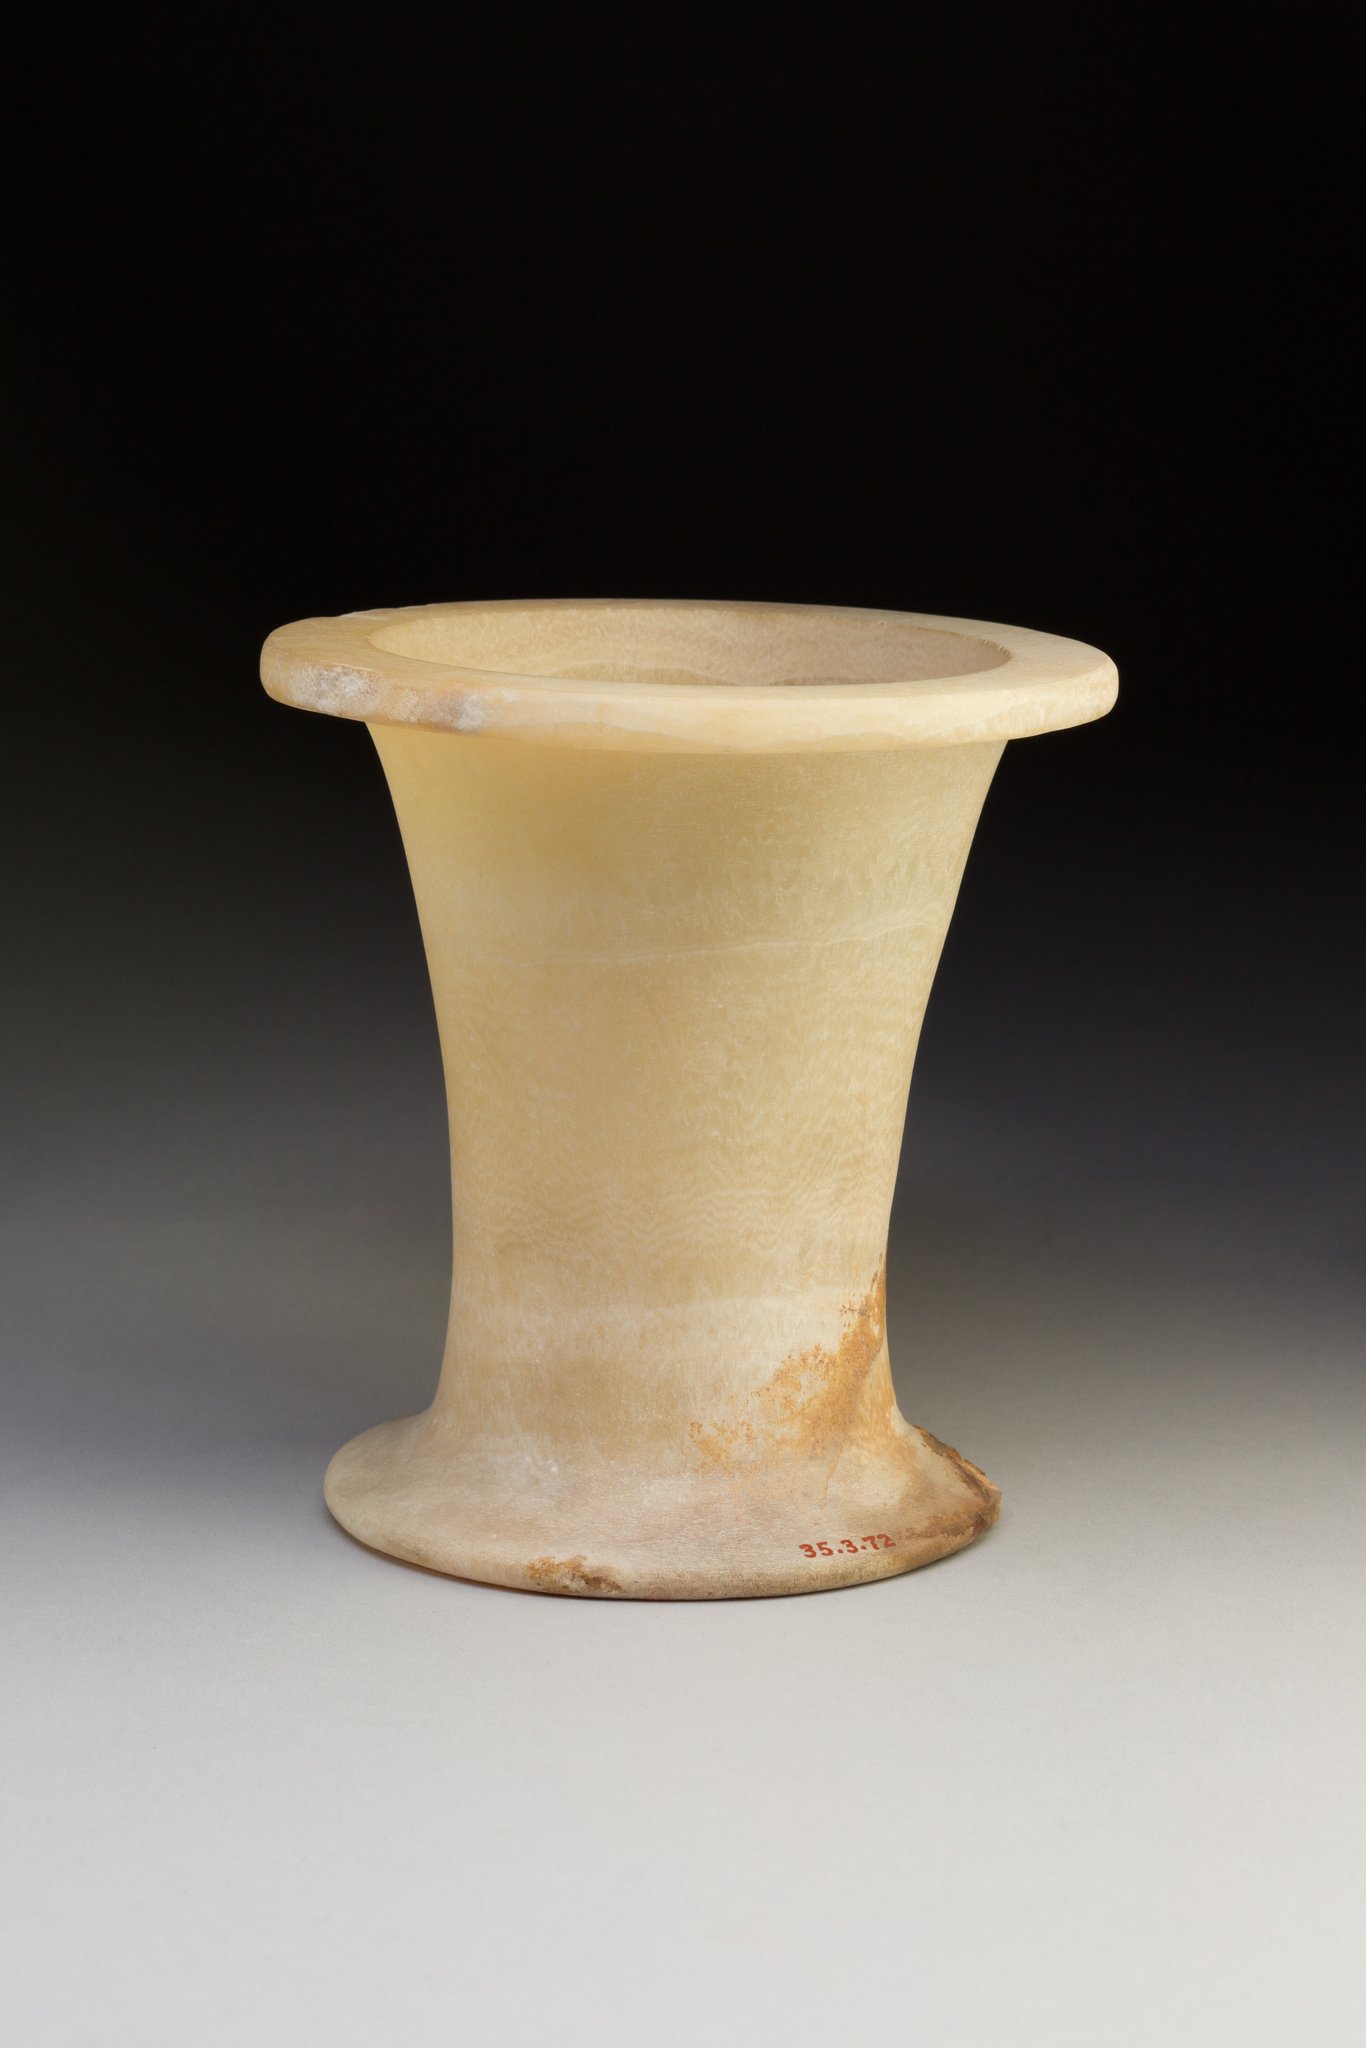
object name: jar, cosmetic, cylindrical, rennefer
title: Cylindrical Jar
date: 1504-1447 BCE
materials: stone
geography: egypt